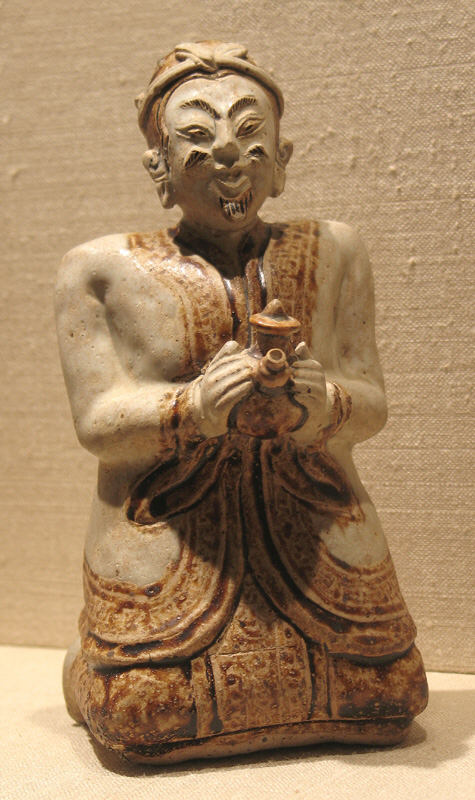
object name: water dropper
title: Water Dropper in the Form of a Kneeling Man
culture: thai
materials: earthenware, glaze, iron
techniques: underglaze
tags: men